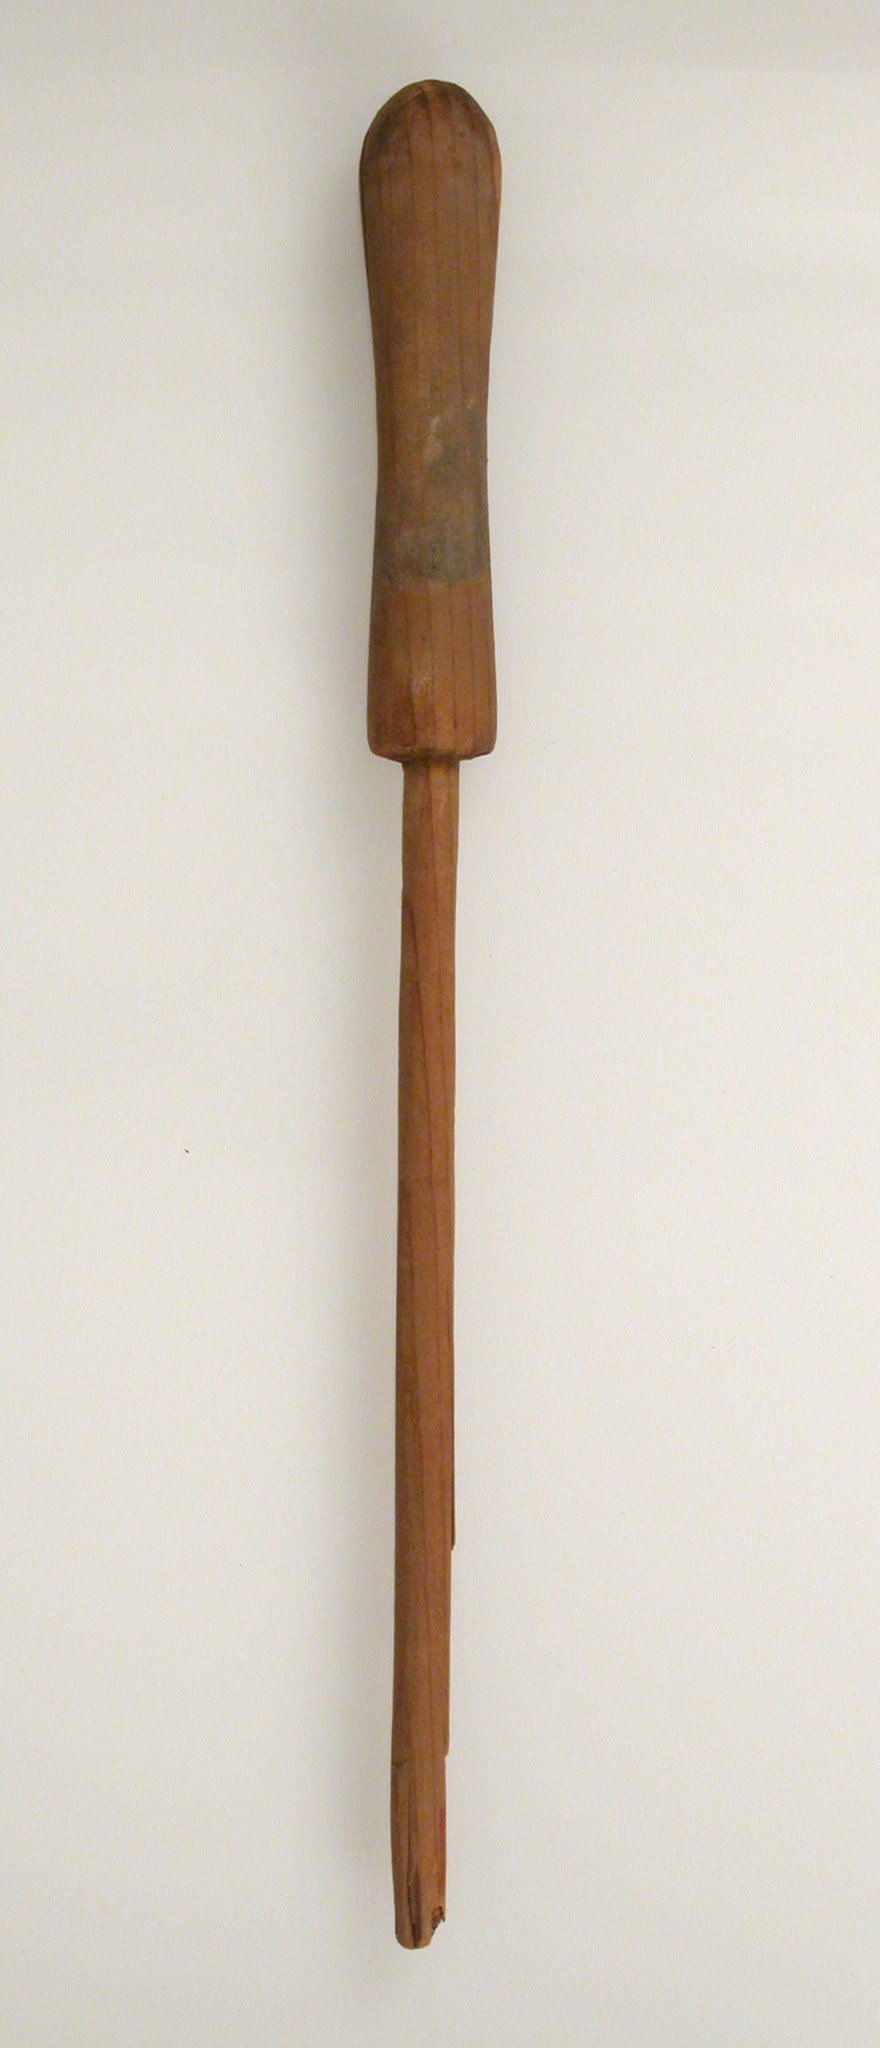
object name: distaff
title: Distaff (?)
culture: coptic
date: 201-500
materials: wood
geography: egypt